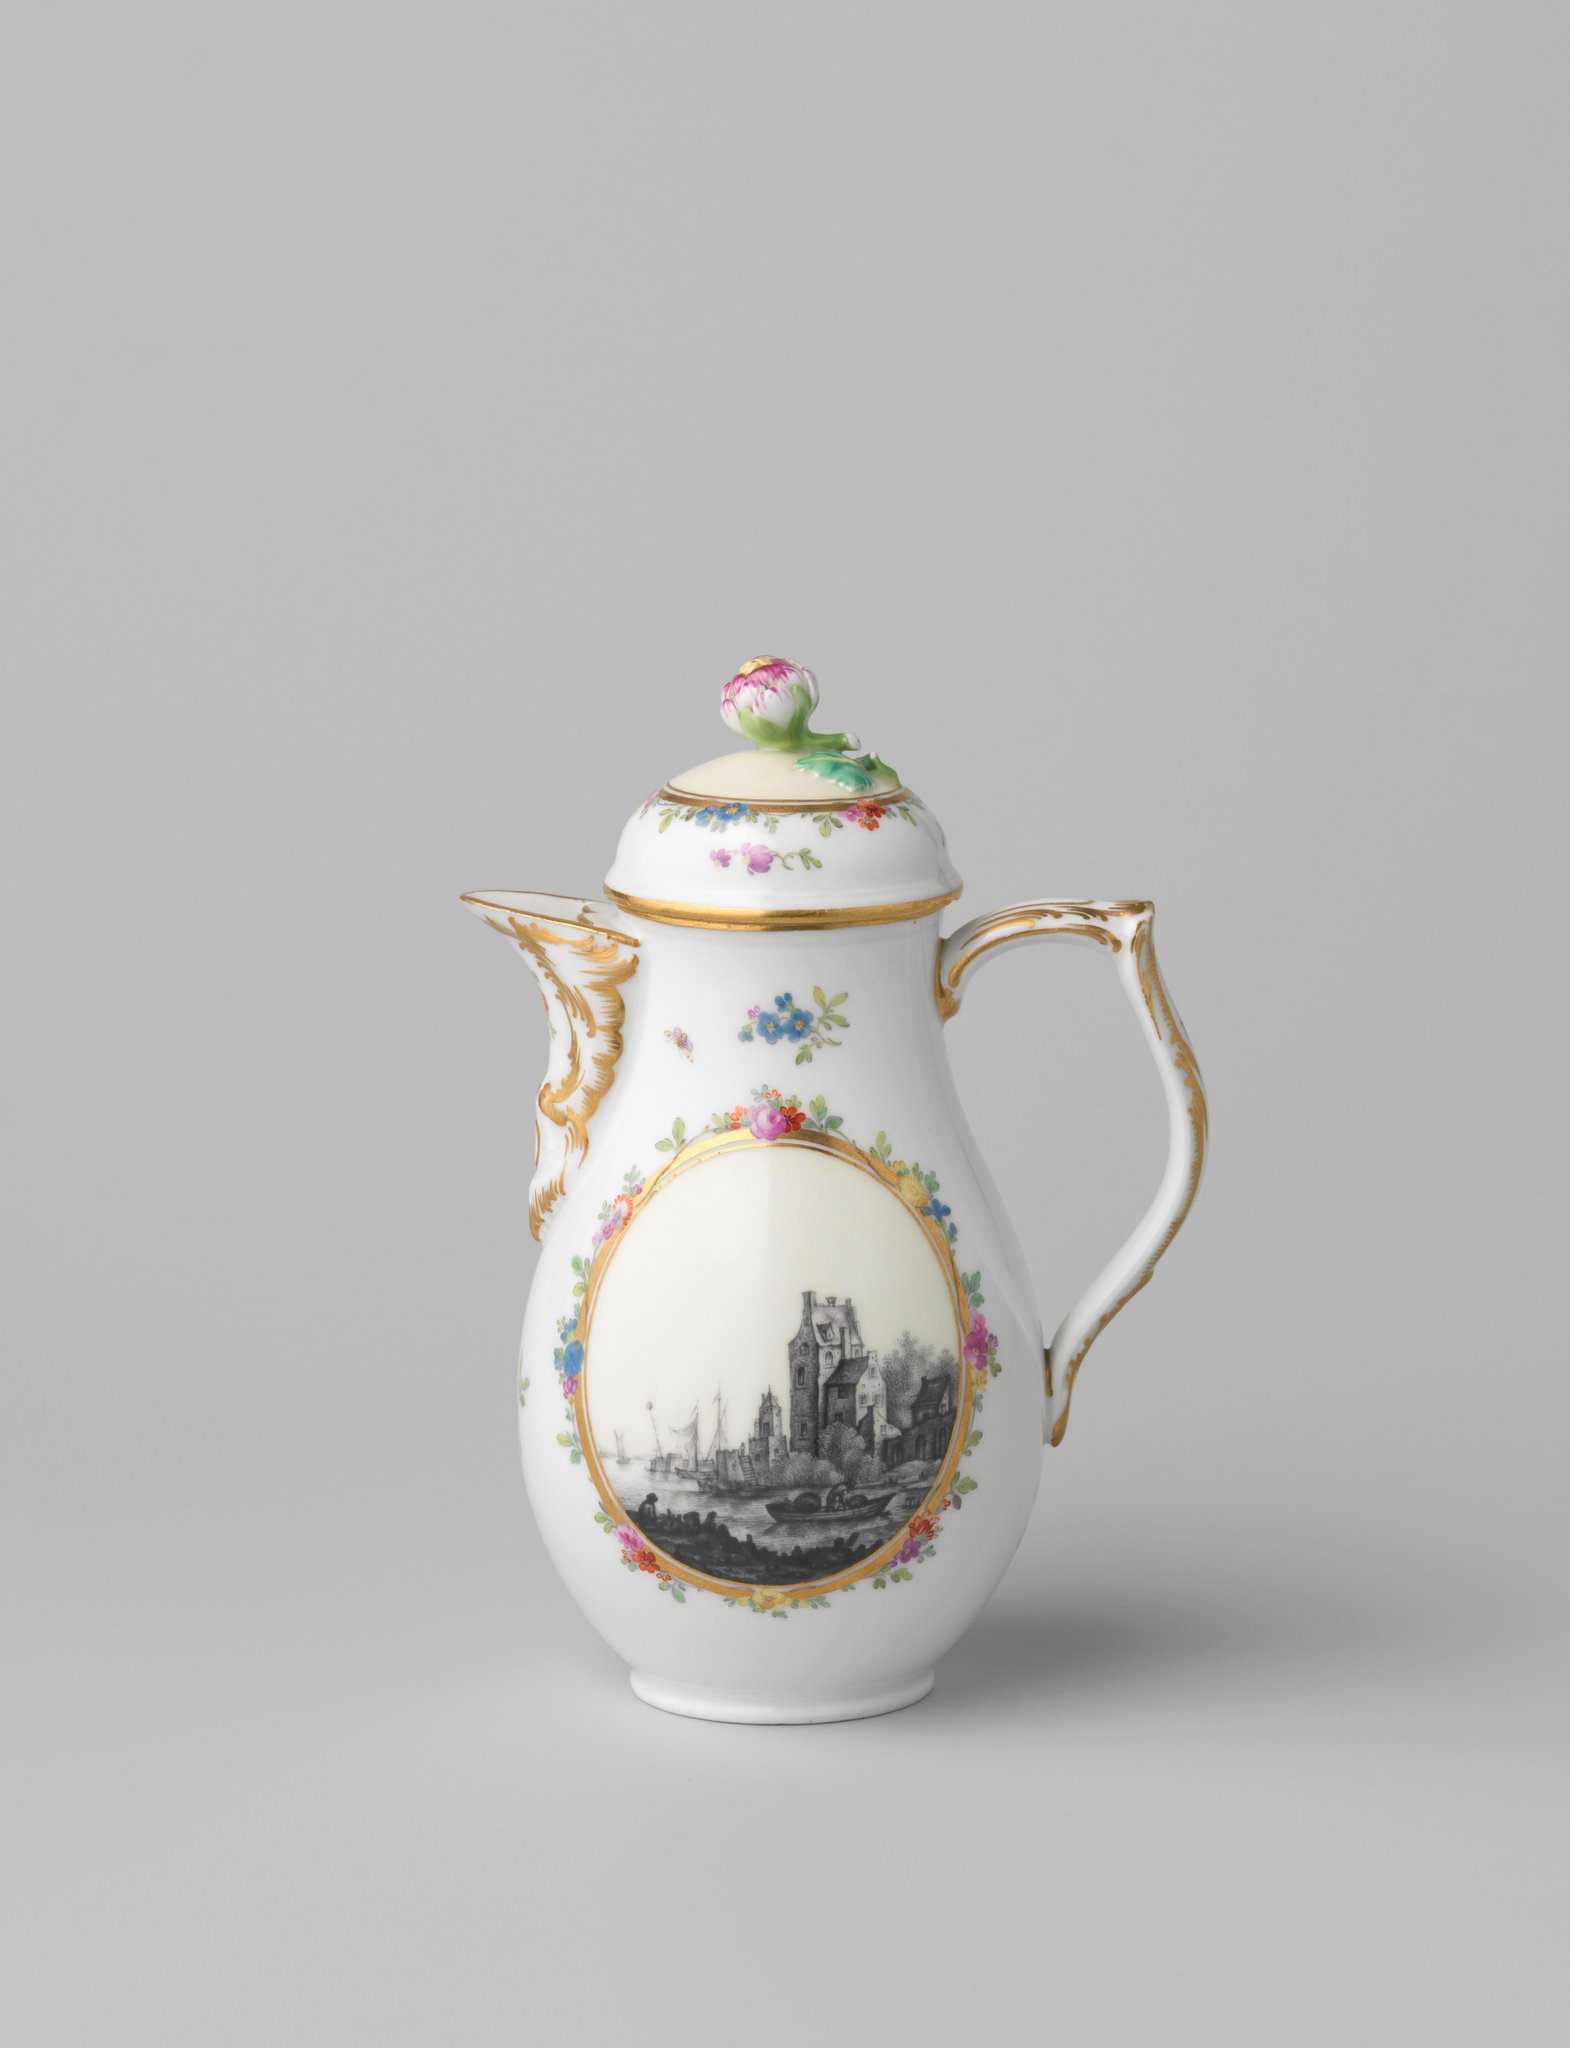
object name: coffee pot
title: Coffee pot with a landscape and flower sprays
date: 1780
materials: glaze, gold, paint, porcelain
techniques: firing, forming, gilding, turning, vitrification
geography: berlin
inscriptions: mark: ‘scepter/ I’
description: Koffiepot van porselein met een peervormig lichaam, C-vormig oor en tuit vanuit de nek en rand. Beschilderd in emailkleuren en goud. Op de buik tweemaal een medaillon van bloemtakken met daarin een landschap. Het oor en de tuit zijn versierd in rocaillestijl. De deksel met een vergelijkbare decoratie; dekselknop in de vorm van een bloem. Gemerkt op de onderzijde met de scepter en I.